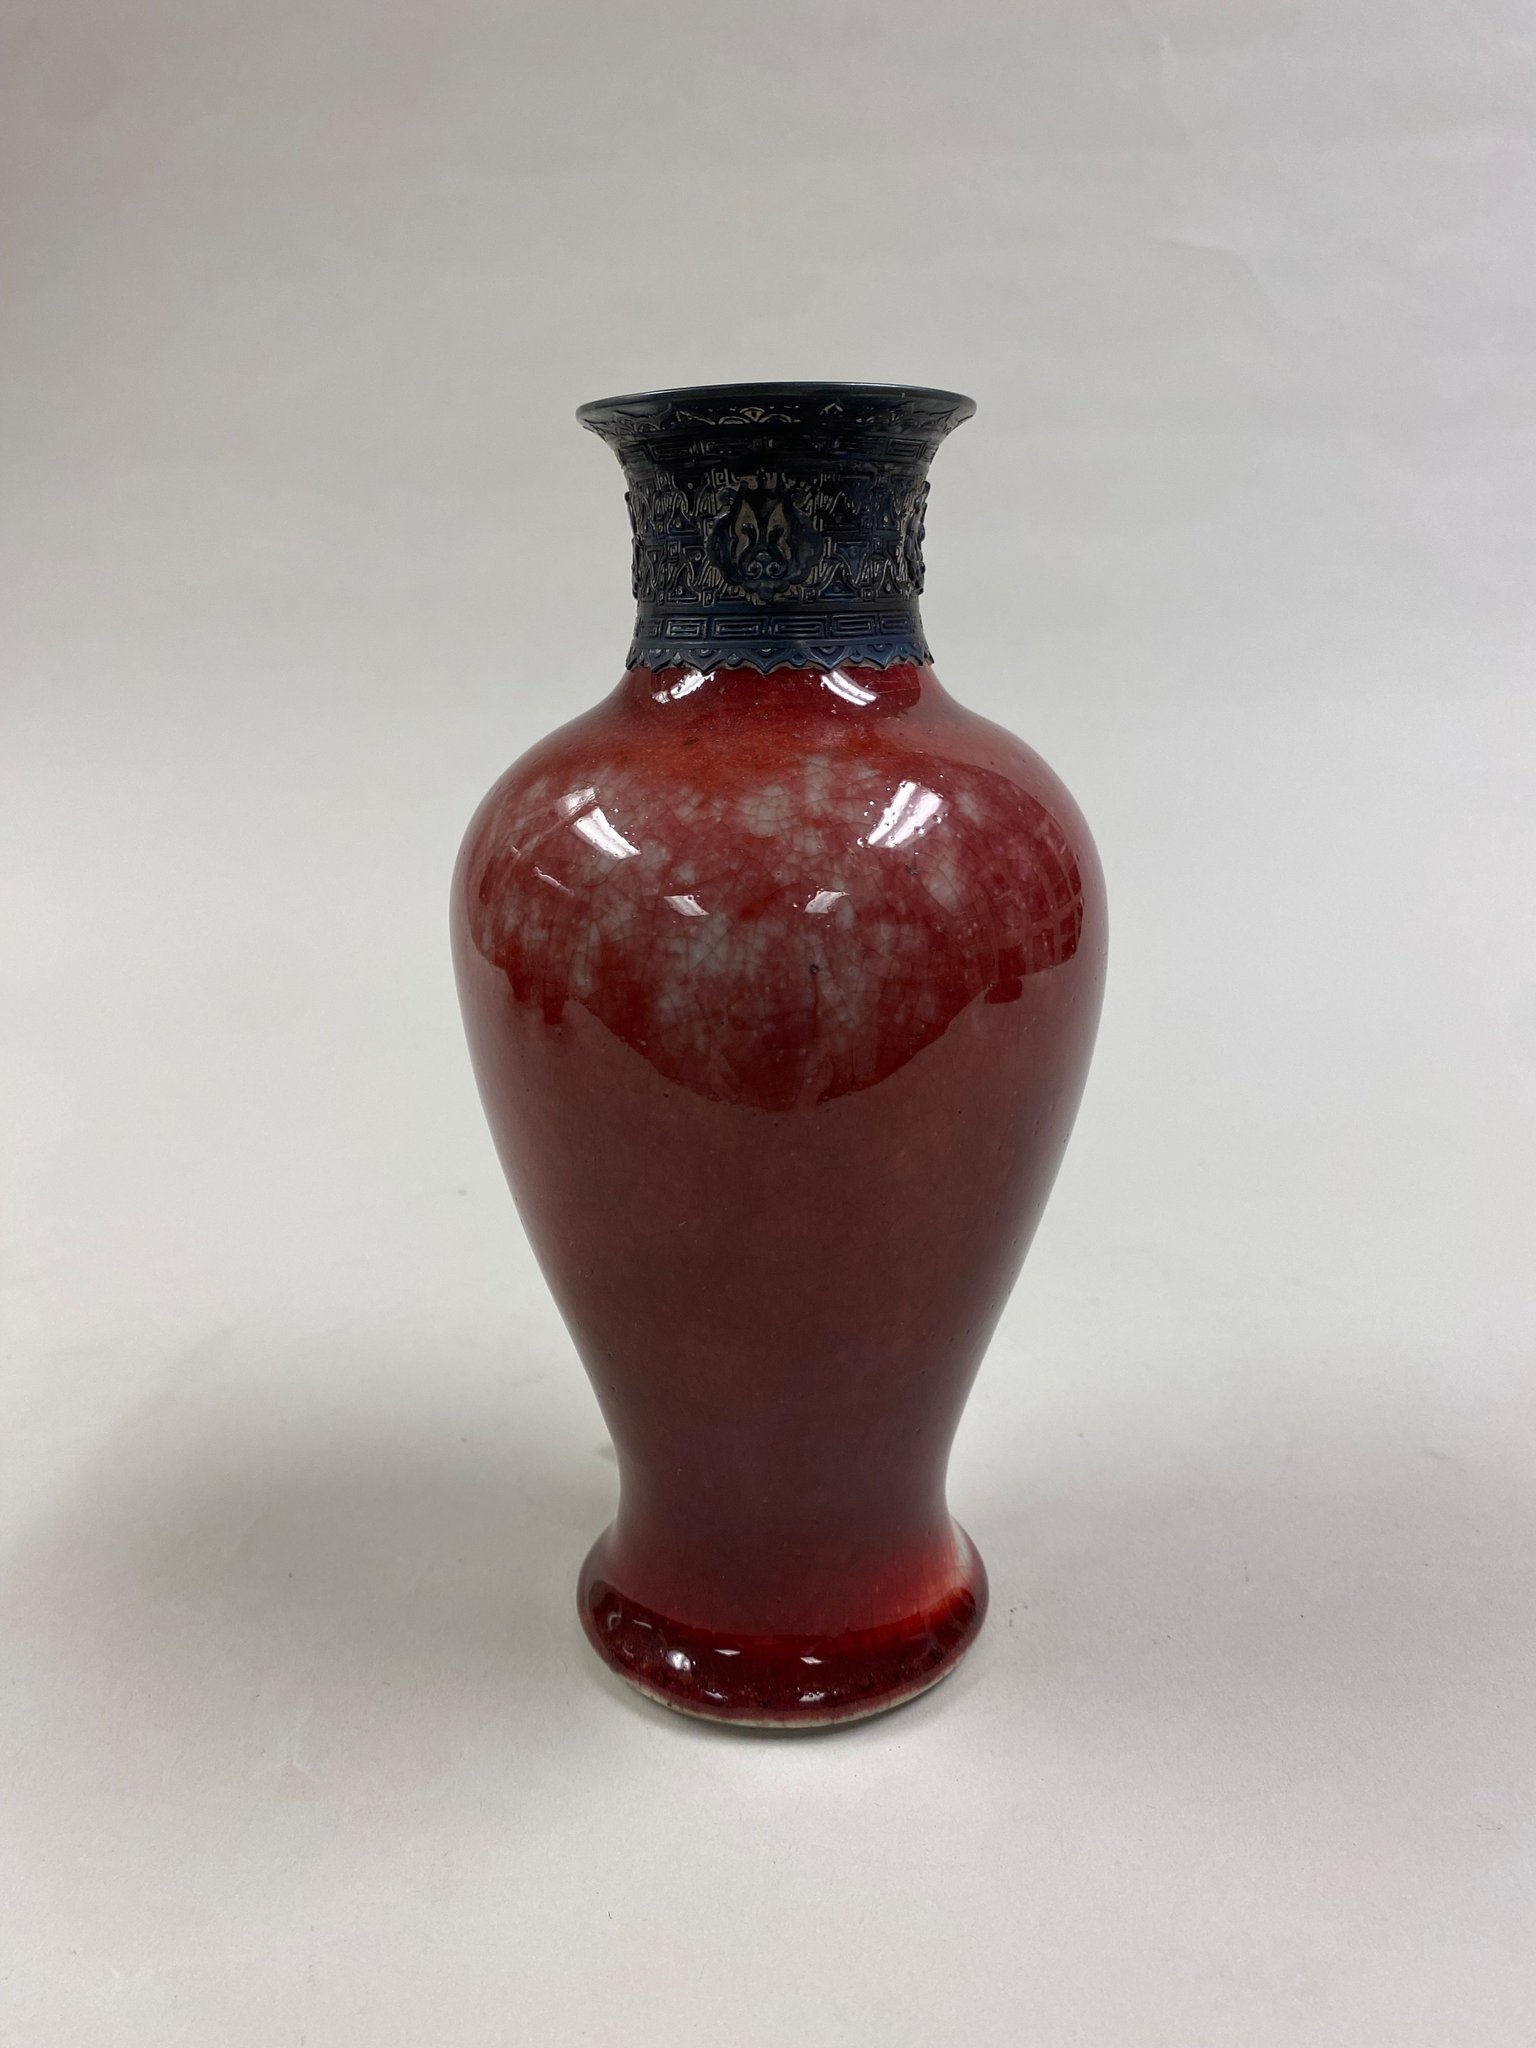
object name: vase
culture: chinese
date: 1667-1733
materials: copper, glaze, porcelain, silver